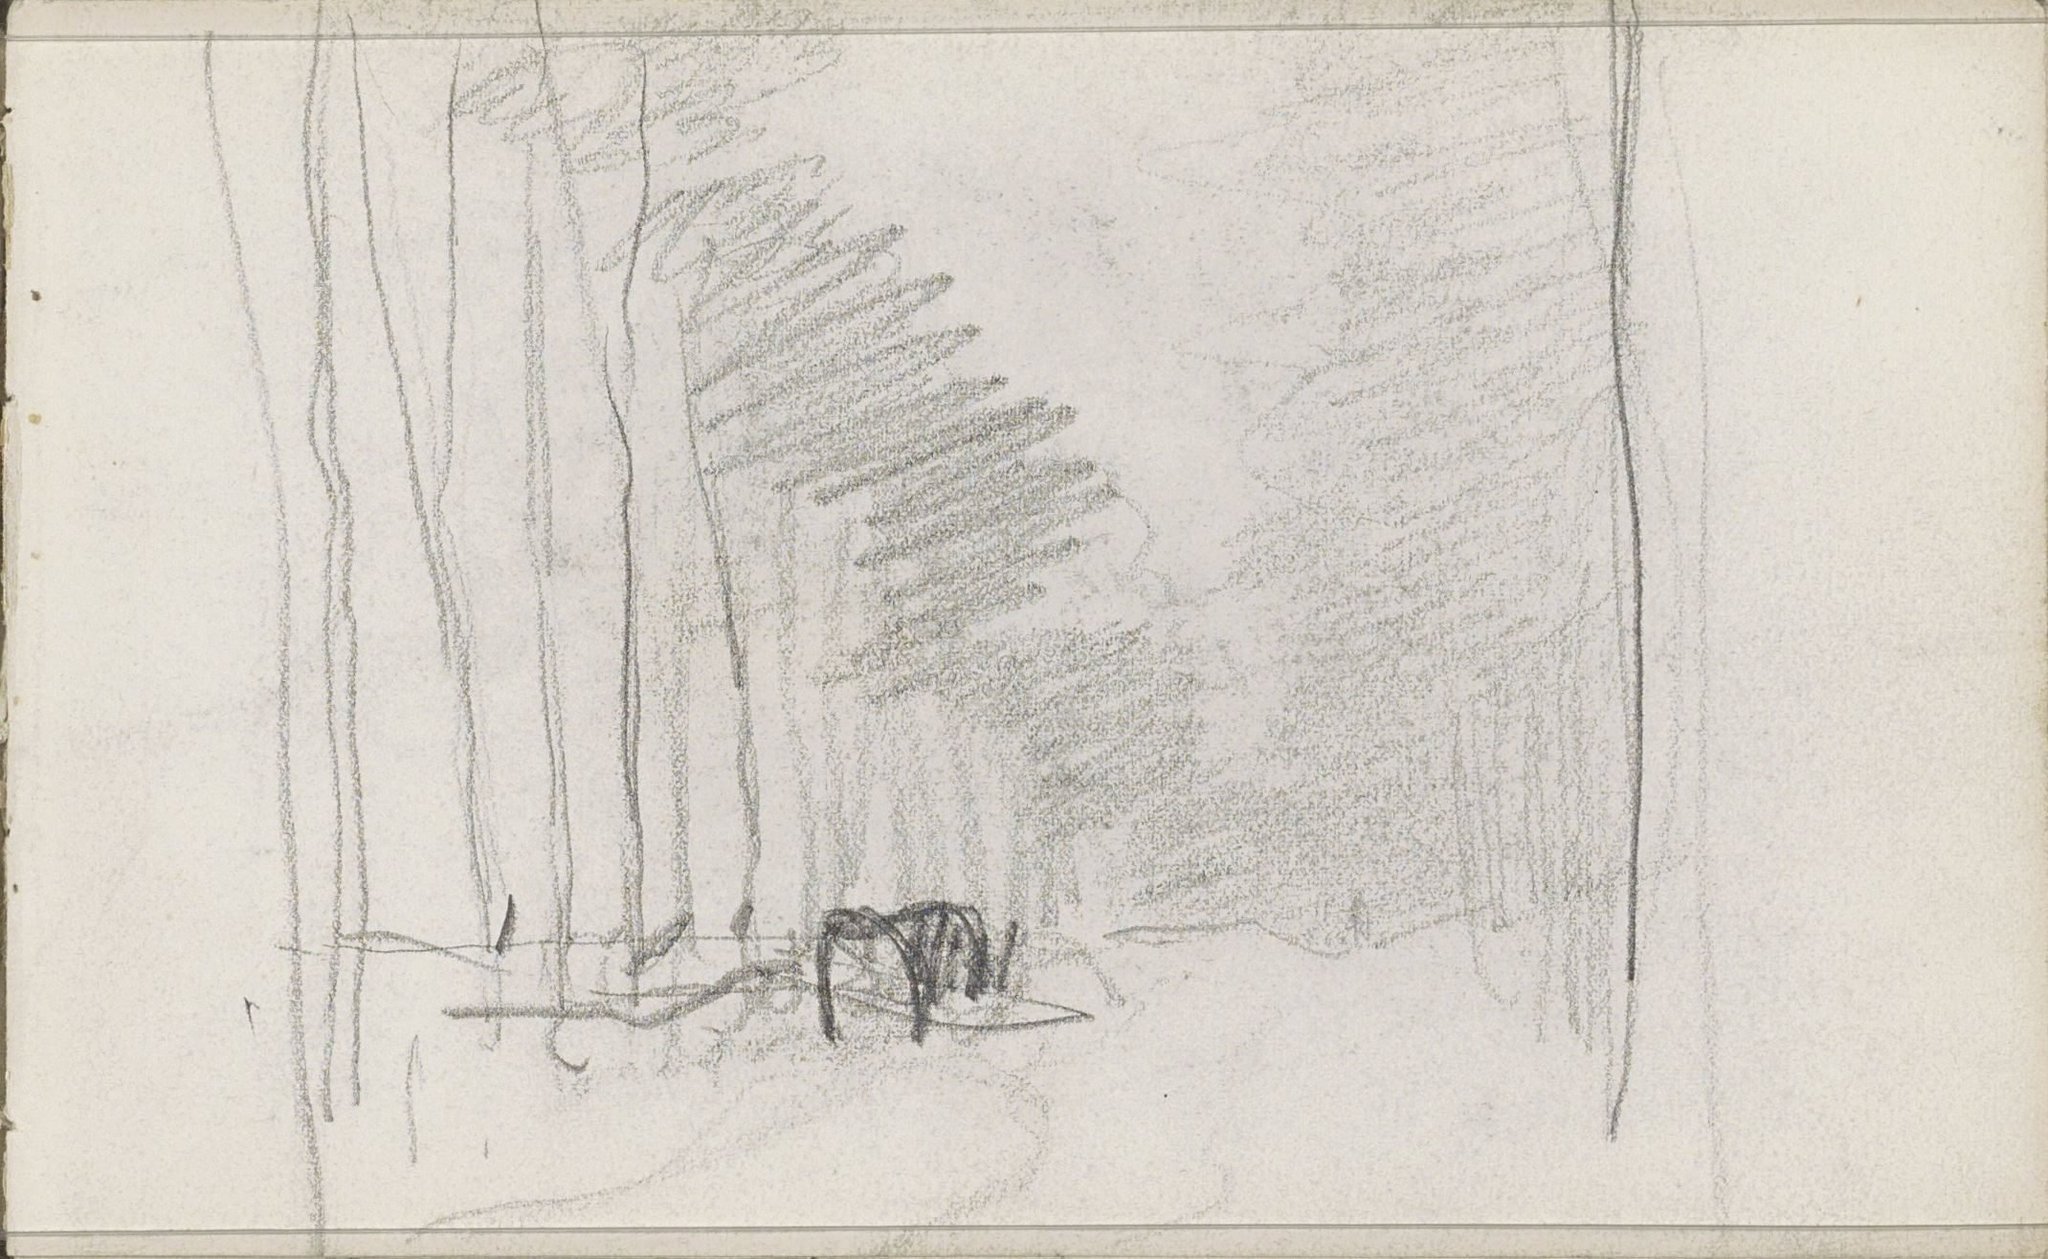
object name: sketchbook leaf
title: Bomen langs een landweg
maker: anton mauve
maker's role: draughtsman, painter, print maker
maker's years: 1838-1888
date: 1848-1888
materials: paper, pencil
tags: road, path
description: Blad 7 recto uit een schetsboek met 43 bladen.